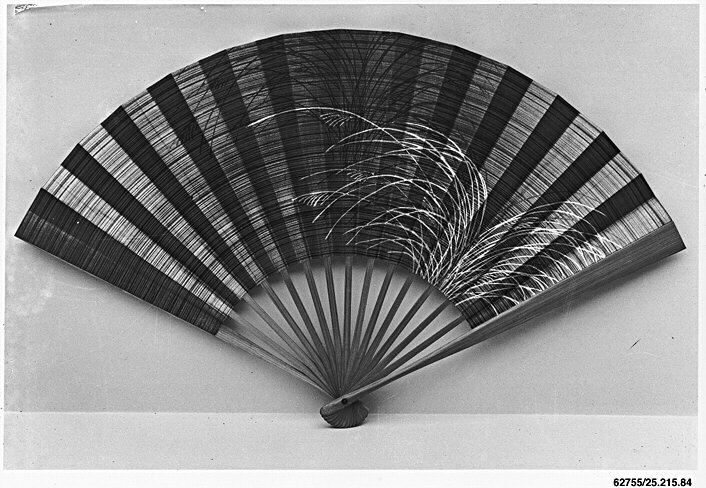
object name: folding fan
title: Fan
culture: japanese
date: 1901-2000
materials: metal, paint, paper